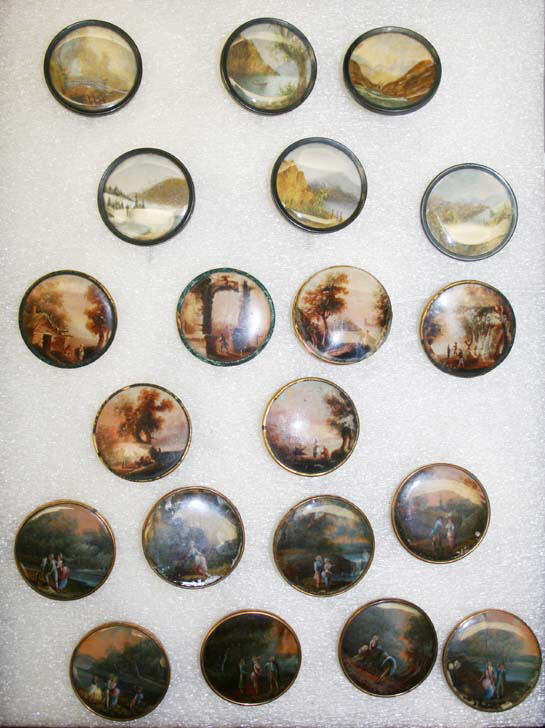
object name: button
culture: french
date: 1775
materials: ivory, metal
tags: men,women,landscapes